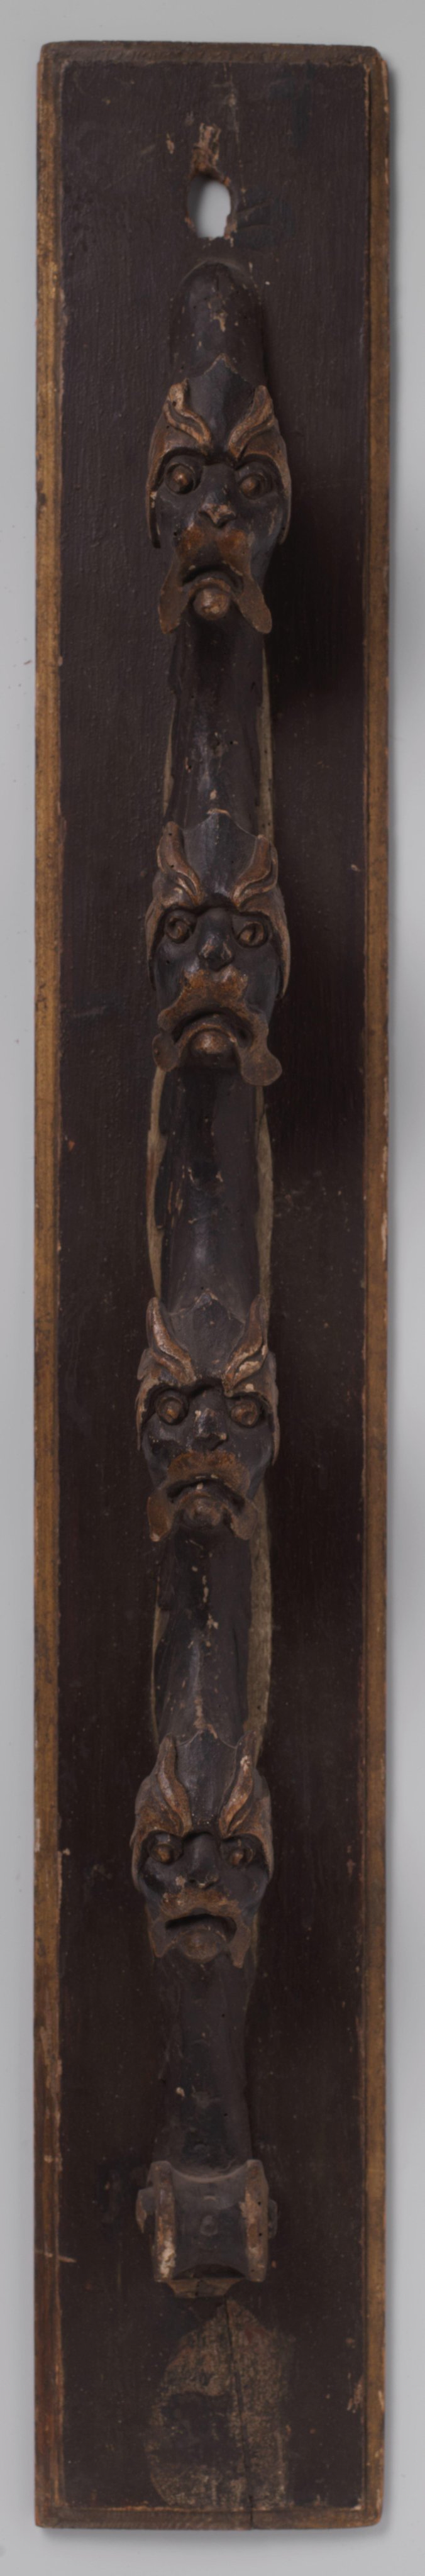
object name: rack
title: Wapenrek in twee delen, versierd met dierenkoppen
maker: Anonymous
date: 1400-1950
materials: paint, wood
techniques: gilding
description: Wapenrek, bestaande uit twee delen (A en B), elk versierd met vier dierenkoppen.